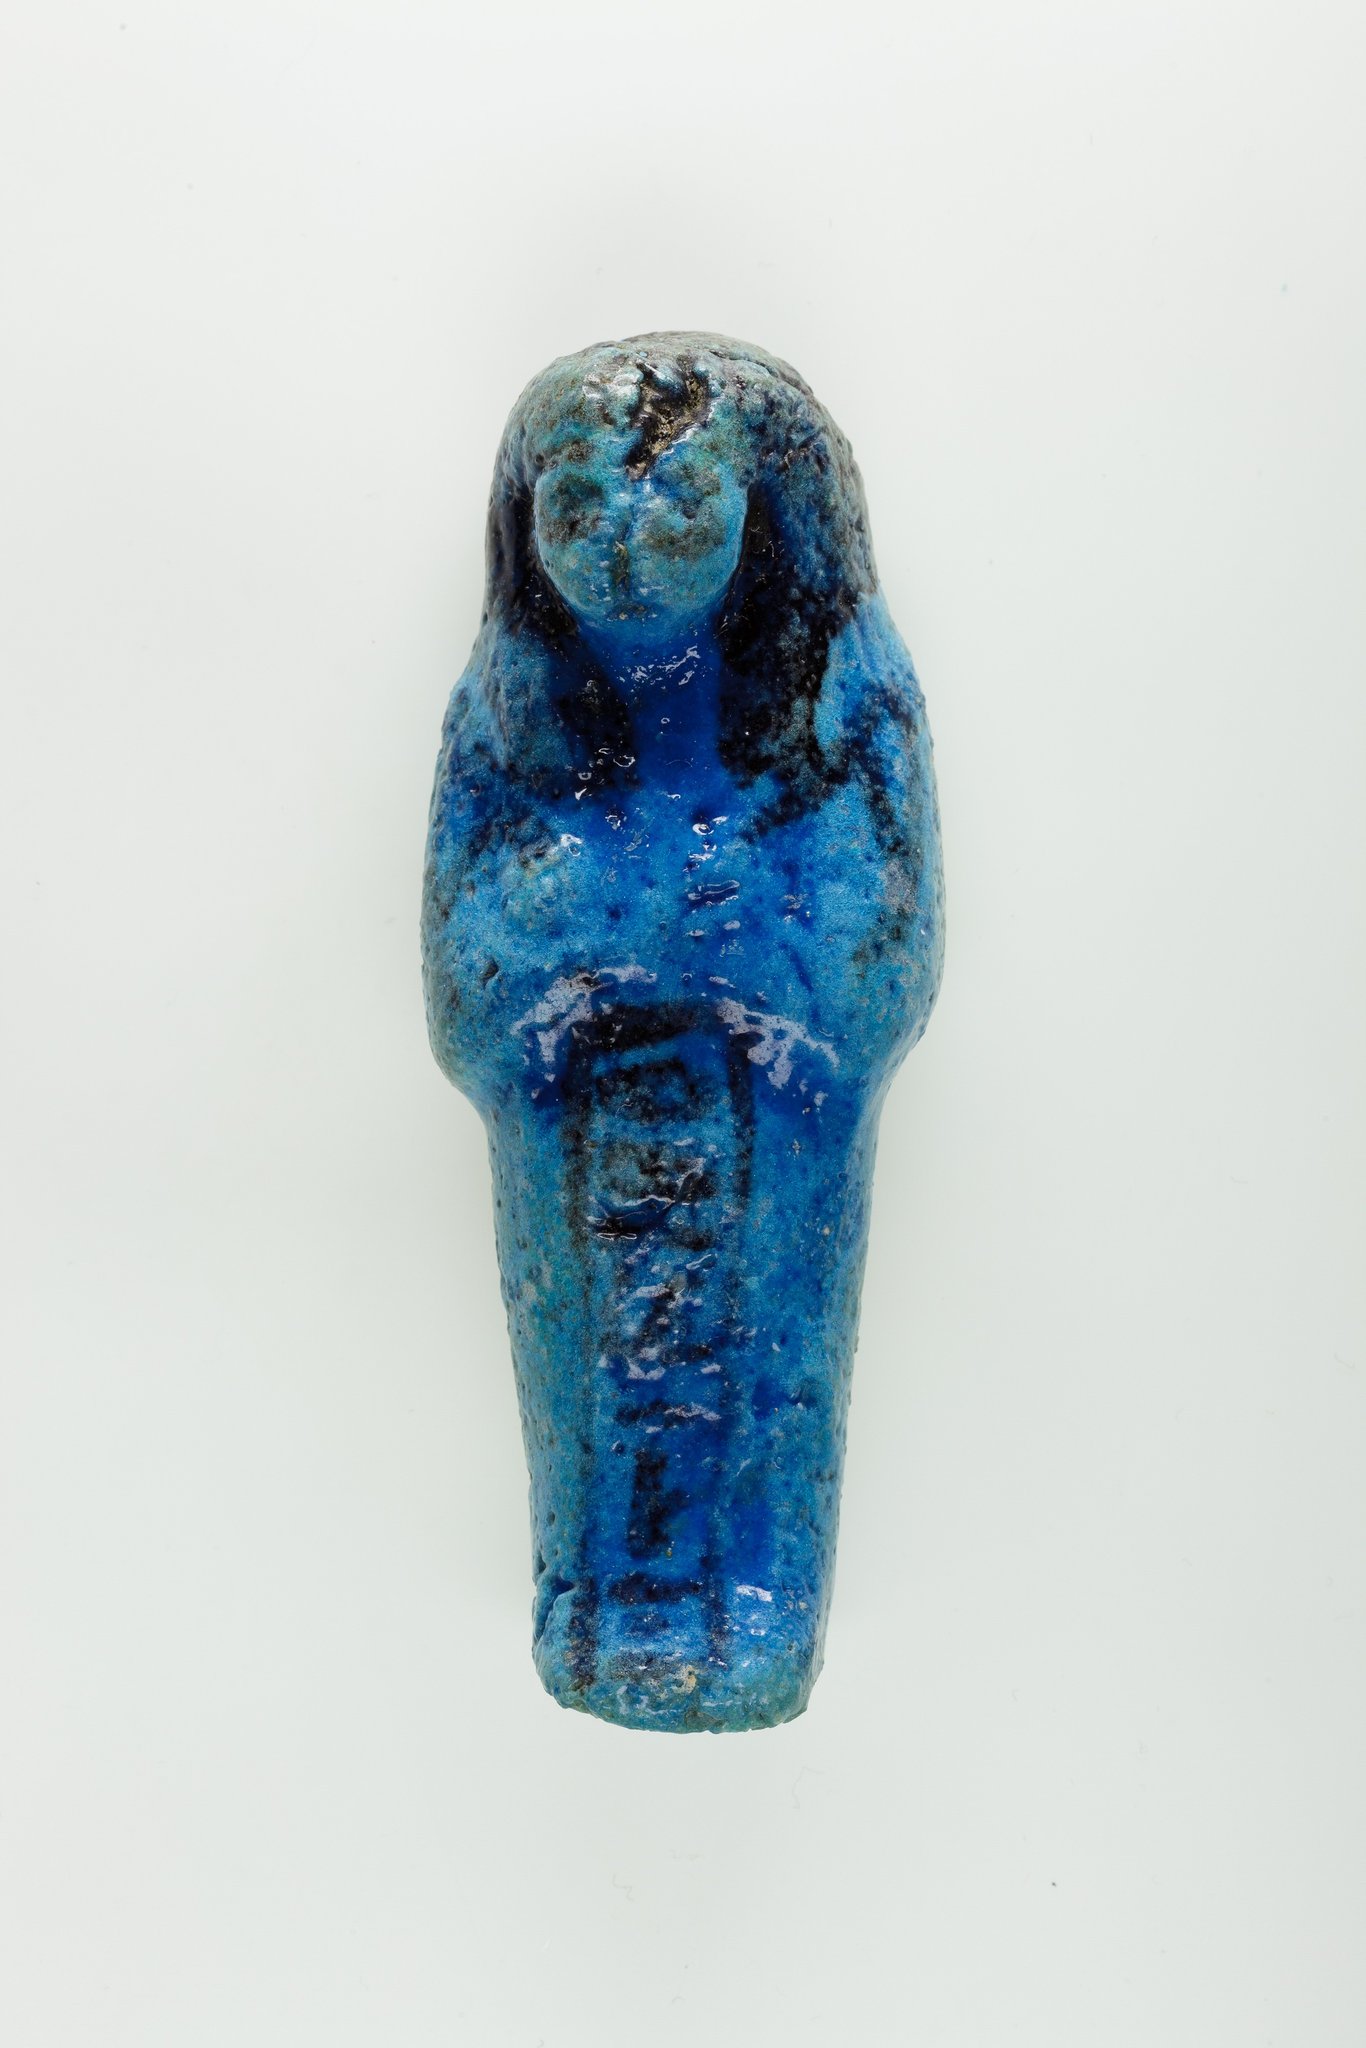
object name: shabti, worker, nauny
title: Worker Shabti of Nauny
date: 1050 BCE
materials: faience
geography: egypt